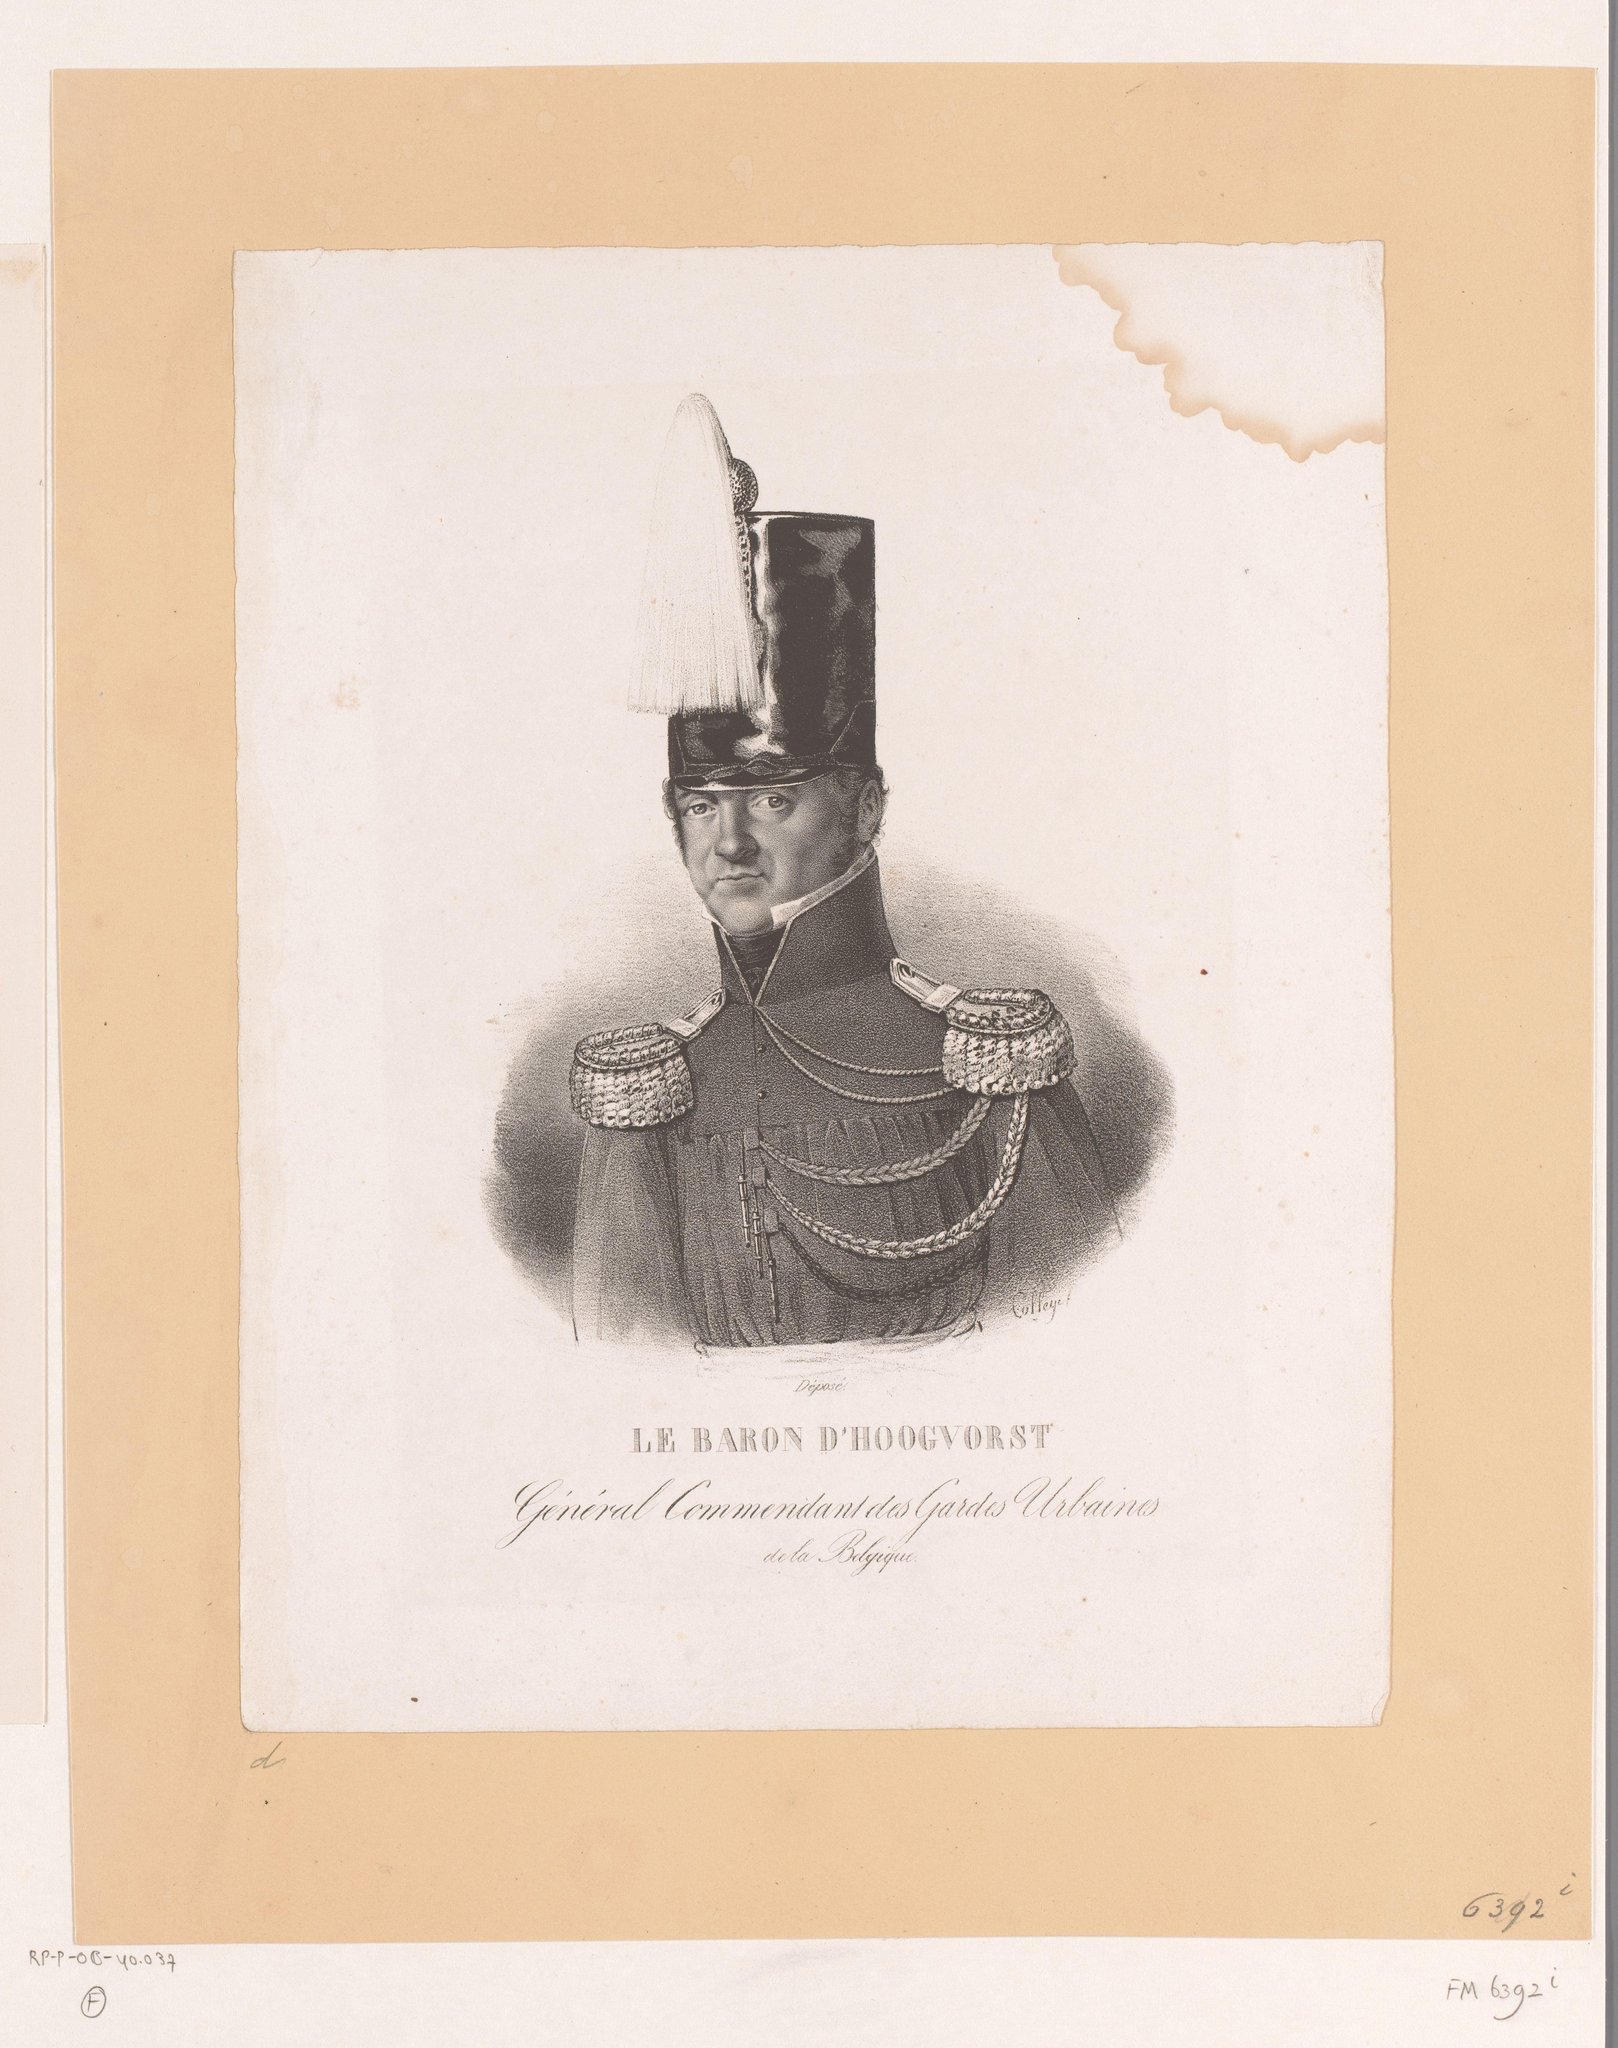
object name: print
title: Portret van de Baron Hoogvorst, 1830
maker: h.i. colleye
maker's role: print maker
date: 1830-1835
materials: paper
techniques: lithograph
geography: belgium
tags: emmanuel van der linden d'hooghvorst, belgische revolutie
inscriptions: collector's mark: Lugt 2228, : ‘Déposé’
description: Portret van Emmanuel van der Linden, baron d'Hooghvorst, ca. 1830. Commandant van de stedelijke schutterij in Brussel. Onderdeel van een groep portretten van personen die aan de Belgische Revolutie hebben deelgenomen of daardoor vermaard zijn.